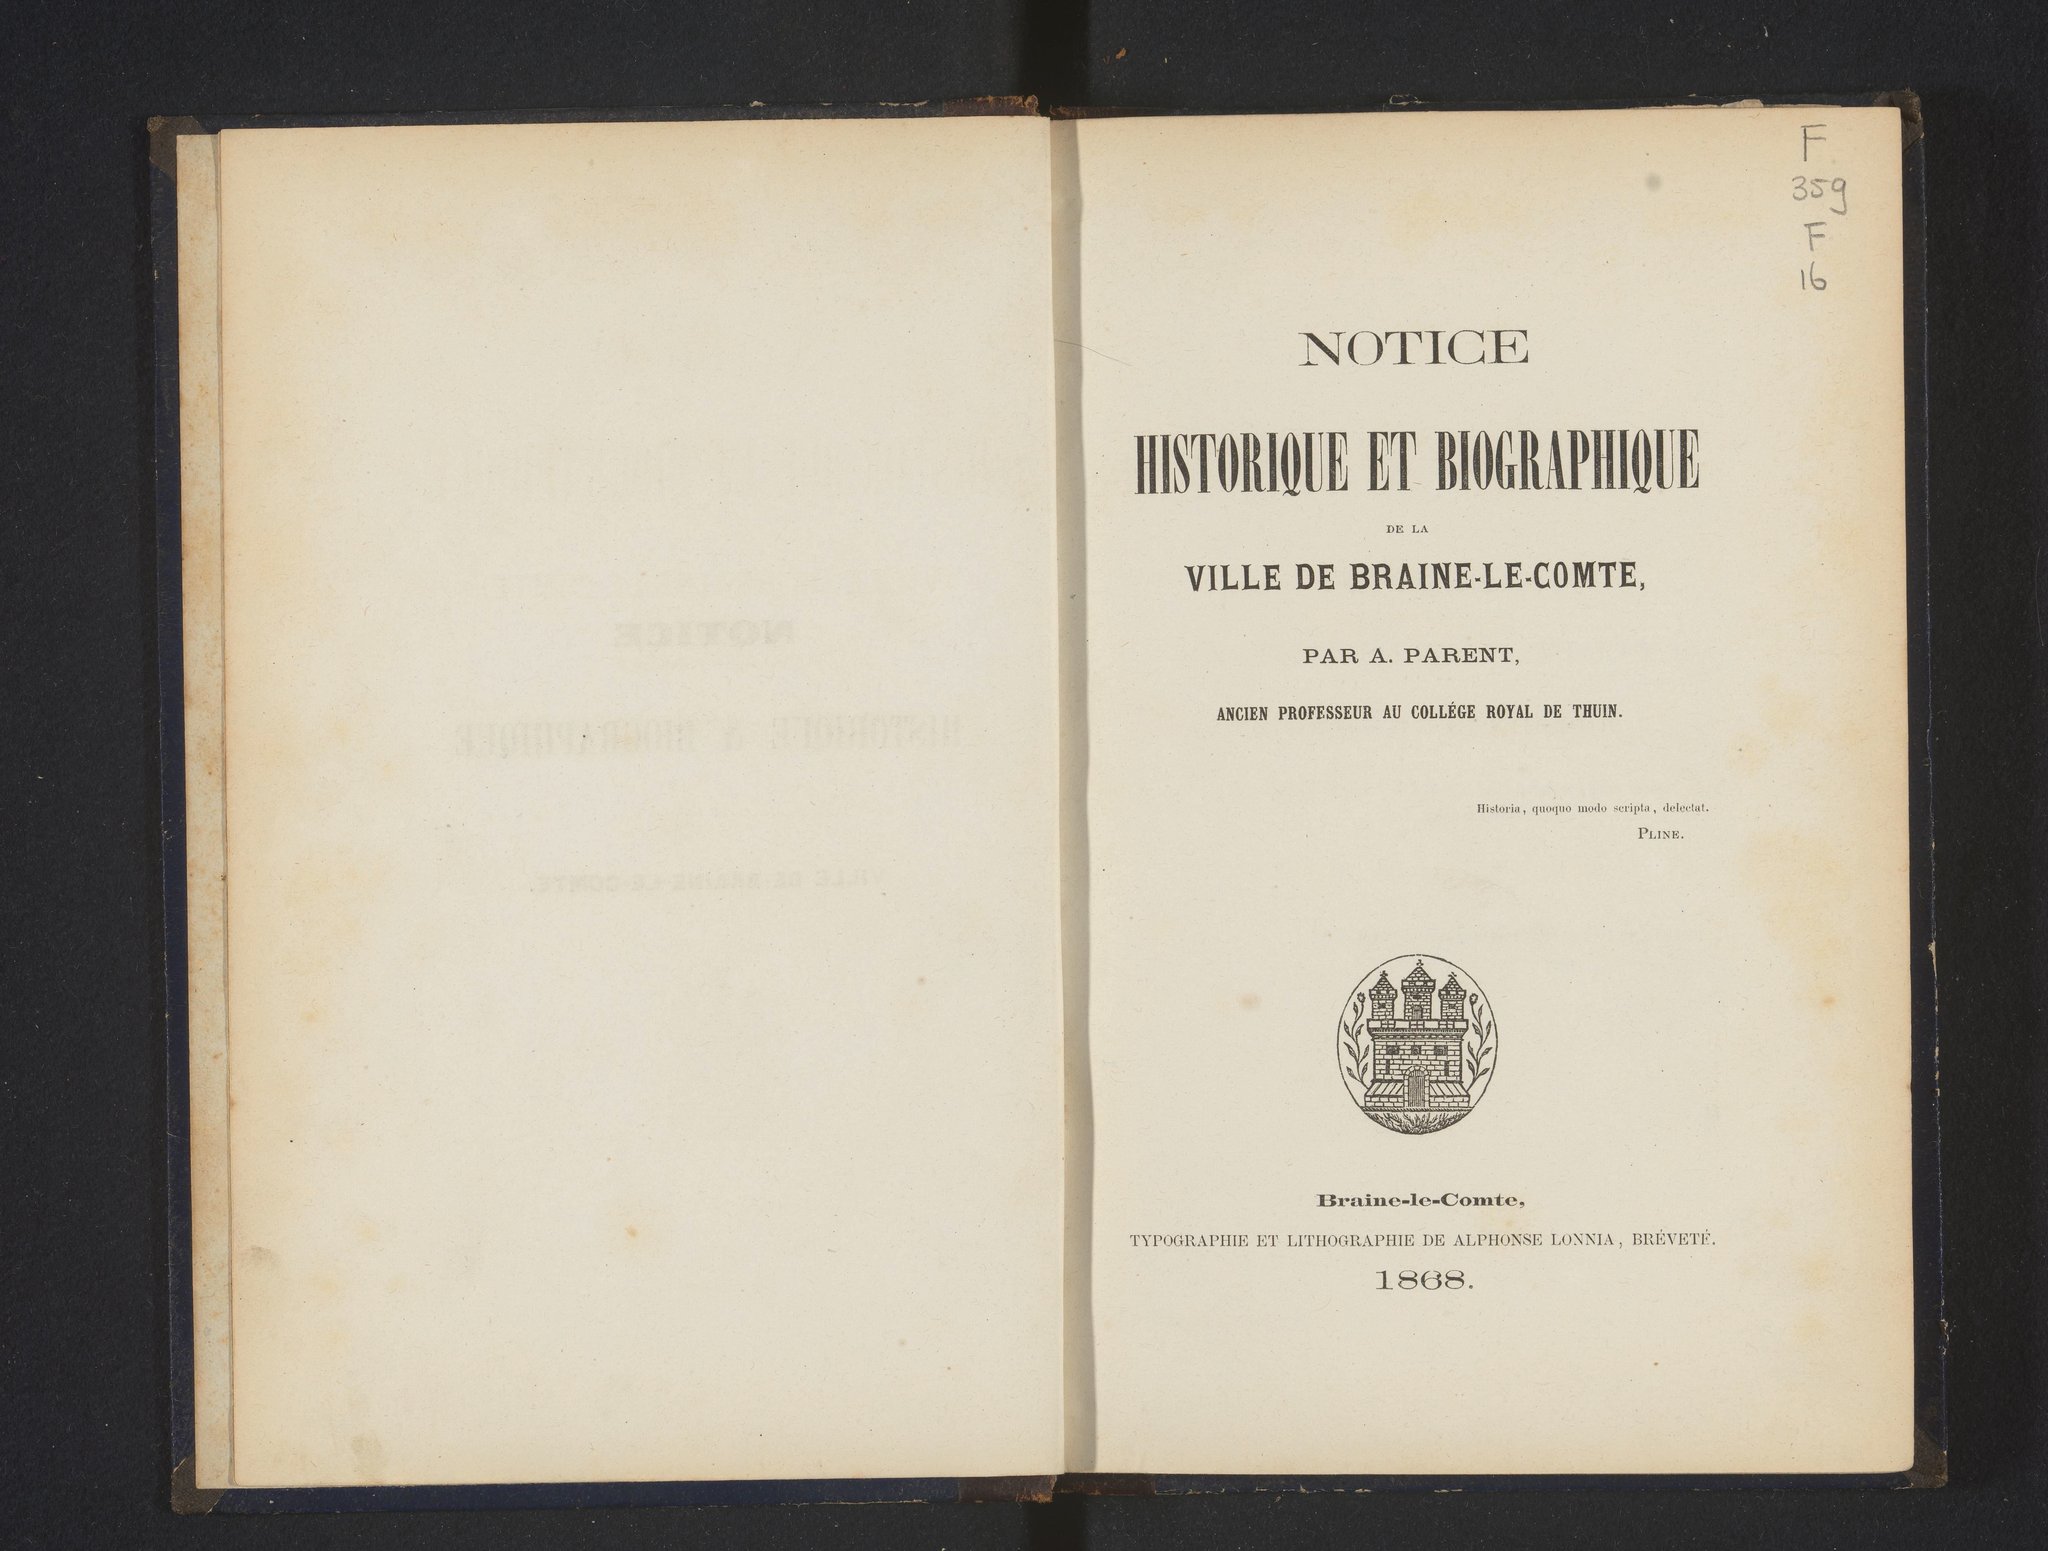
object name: book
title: Notice historique et biographique de la ville de Braine-le-Comte / par A. Parent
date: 1868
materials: cardboard, leather, paper, photographic support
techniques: albumen print, lithograph, printing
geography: braine-le-comte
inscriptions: annotation: ‘AUG/ 2001’, annotation: ‘Très rare/ 220 fcs’